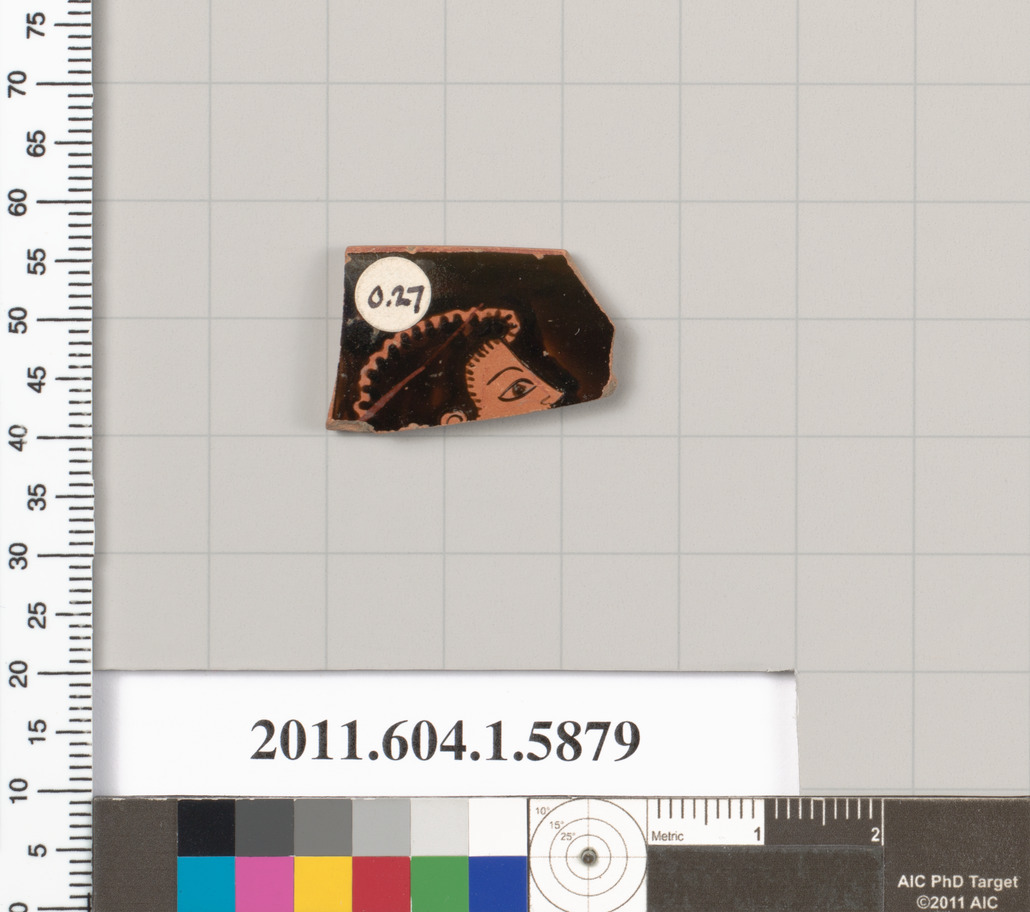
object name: kylix fragment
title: Terracotta rim fragment of a kylix (drinking cup)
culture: greek, attic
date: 520-510 BCE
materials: terracotta